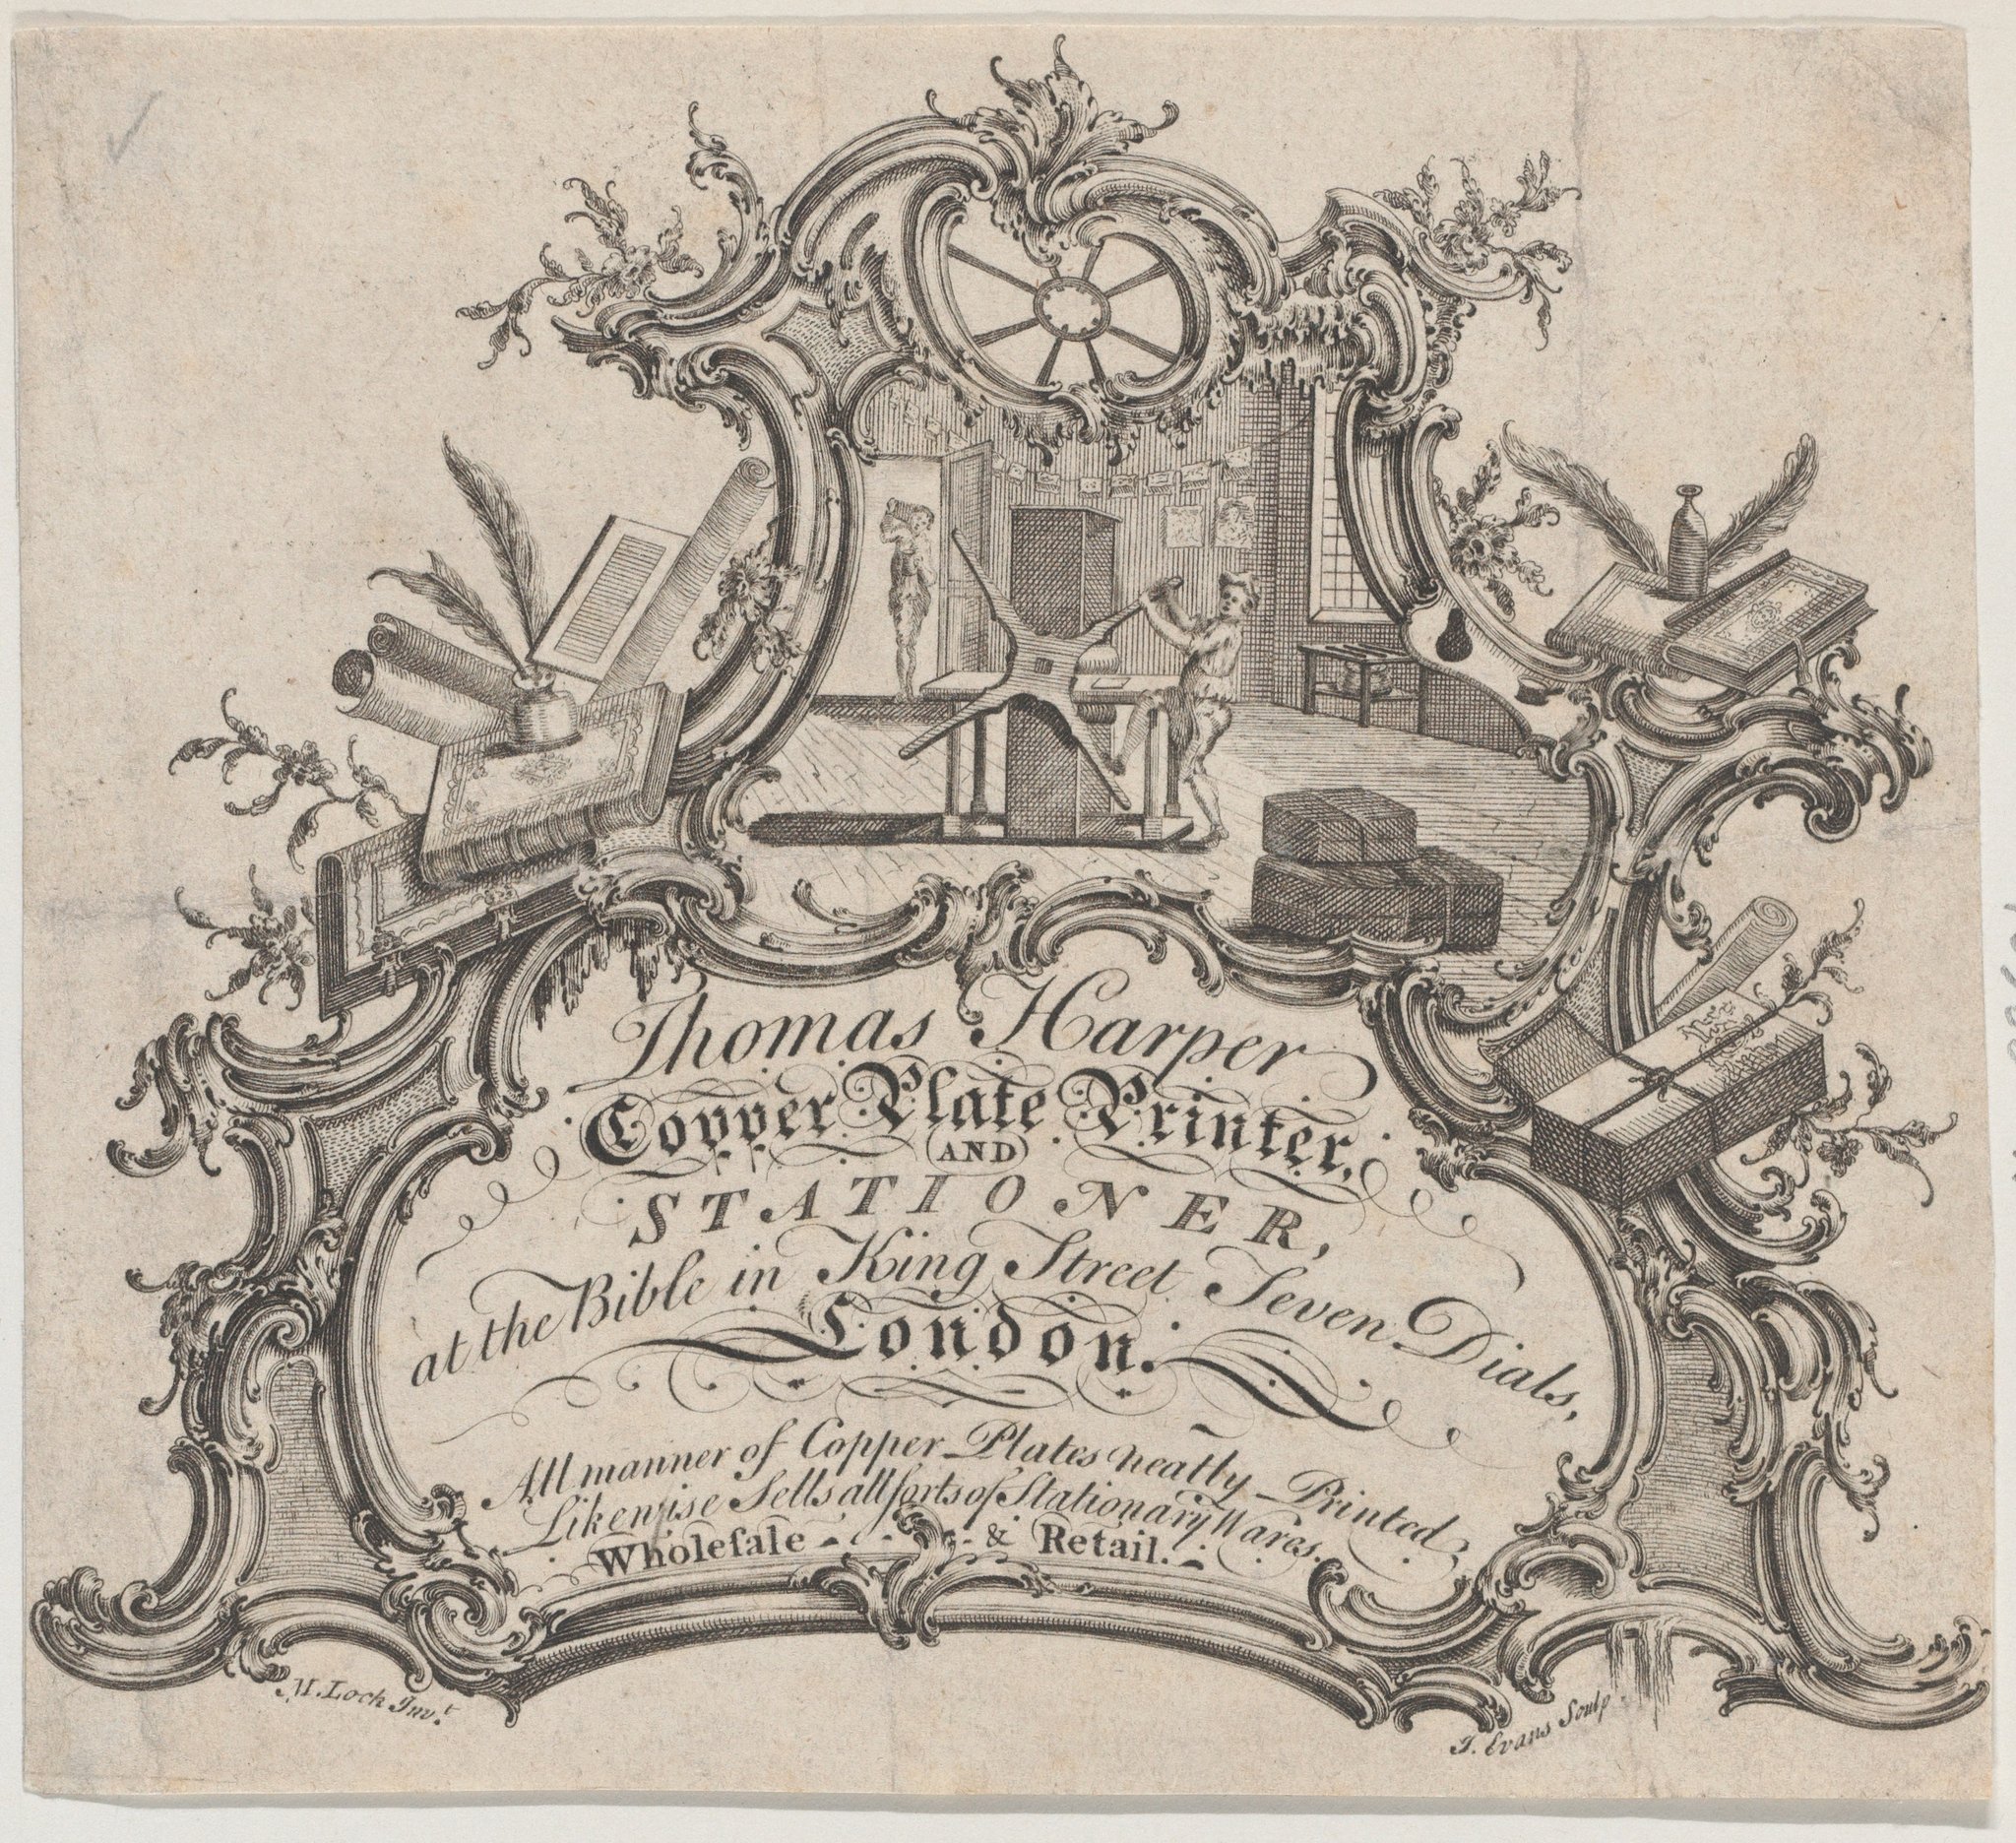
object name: print, trade card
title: Trade Card for Thomas Harper, Copper Plate Printer and Stationer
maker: anonymous, british, 18th century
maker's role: artist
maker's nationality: british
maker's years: 1700-1800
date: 1701-1800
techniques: engraving